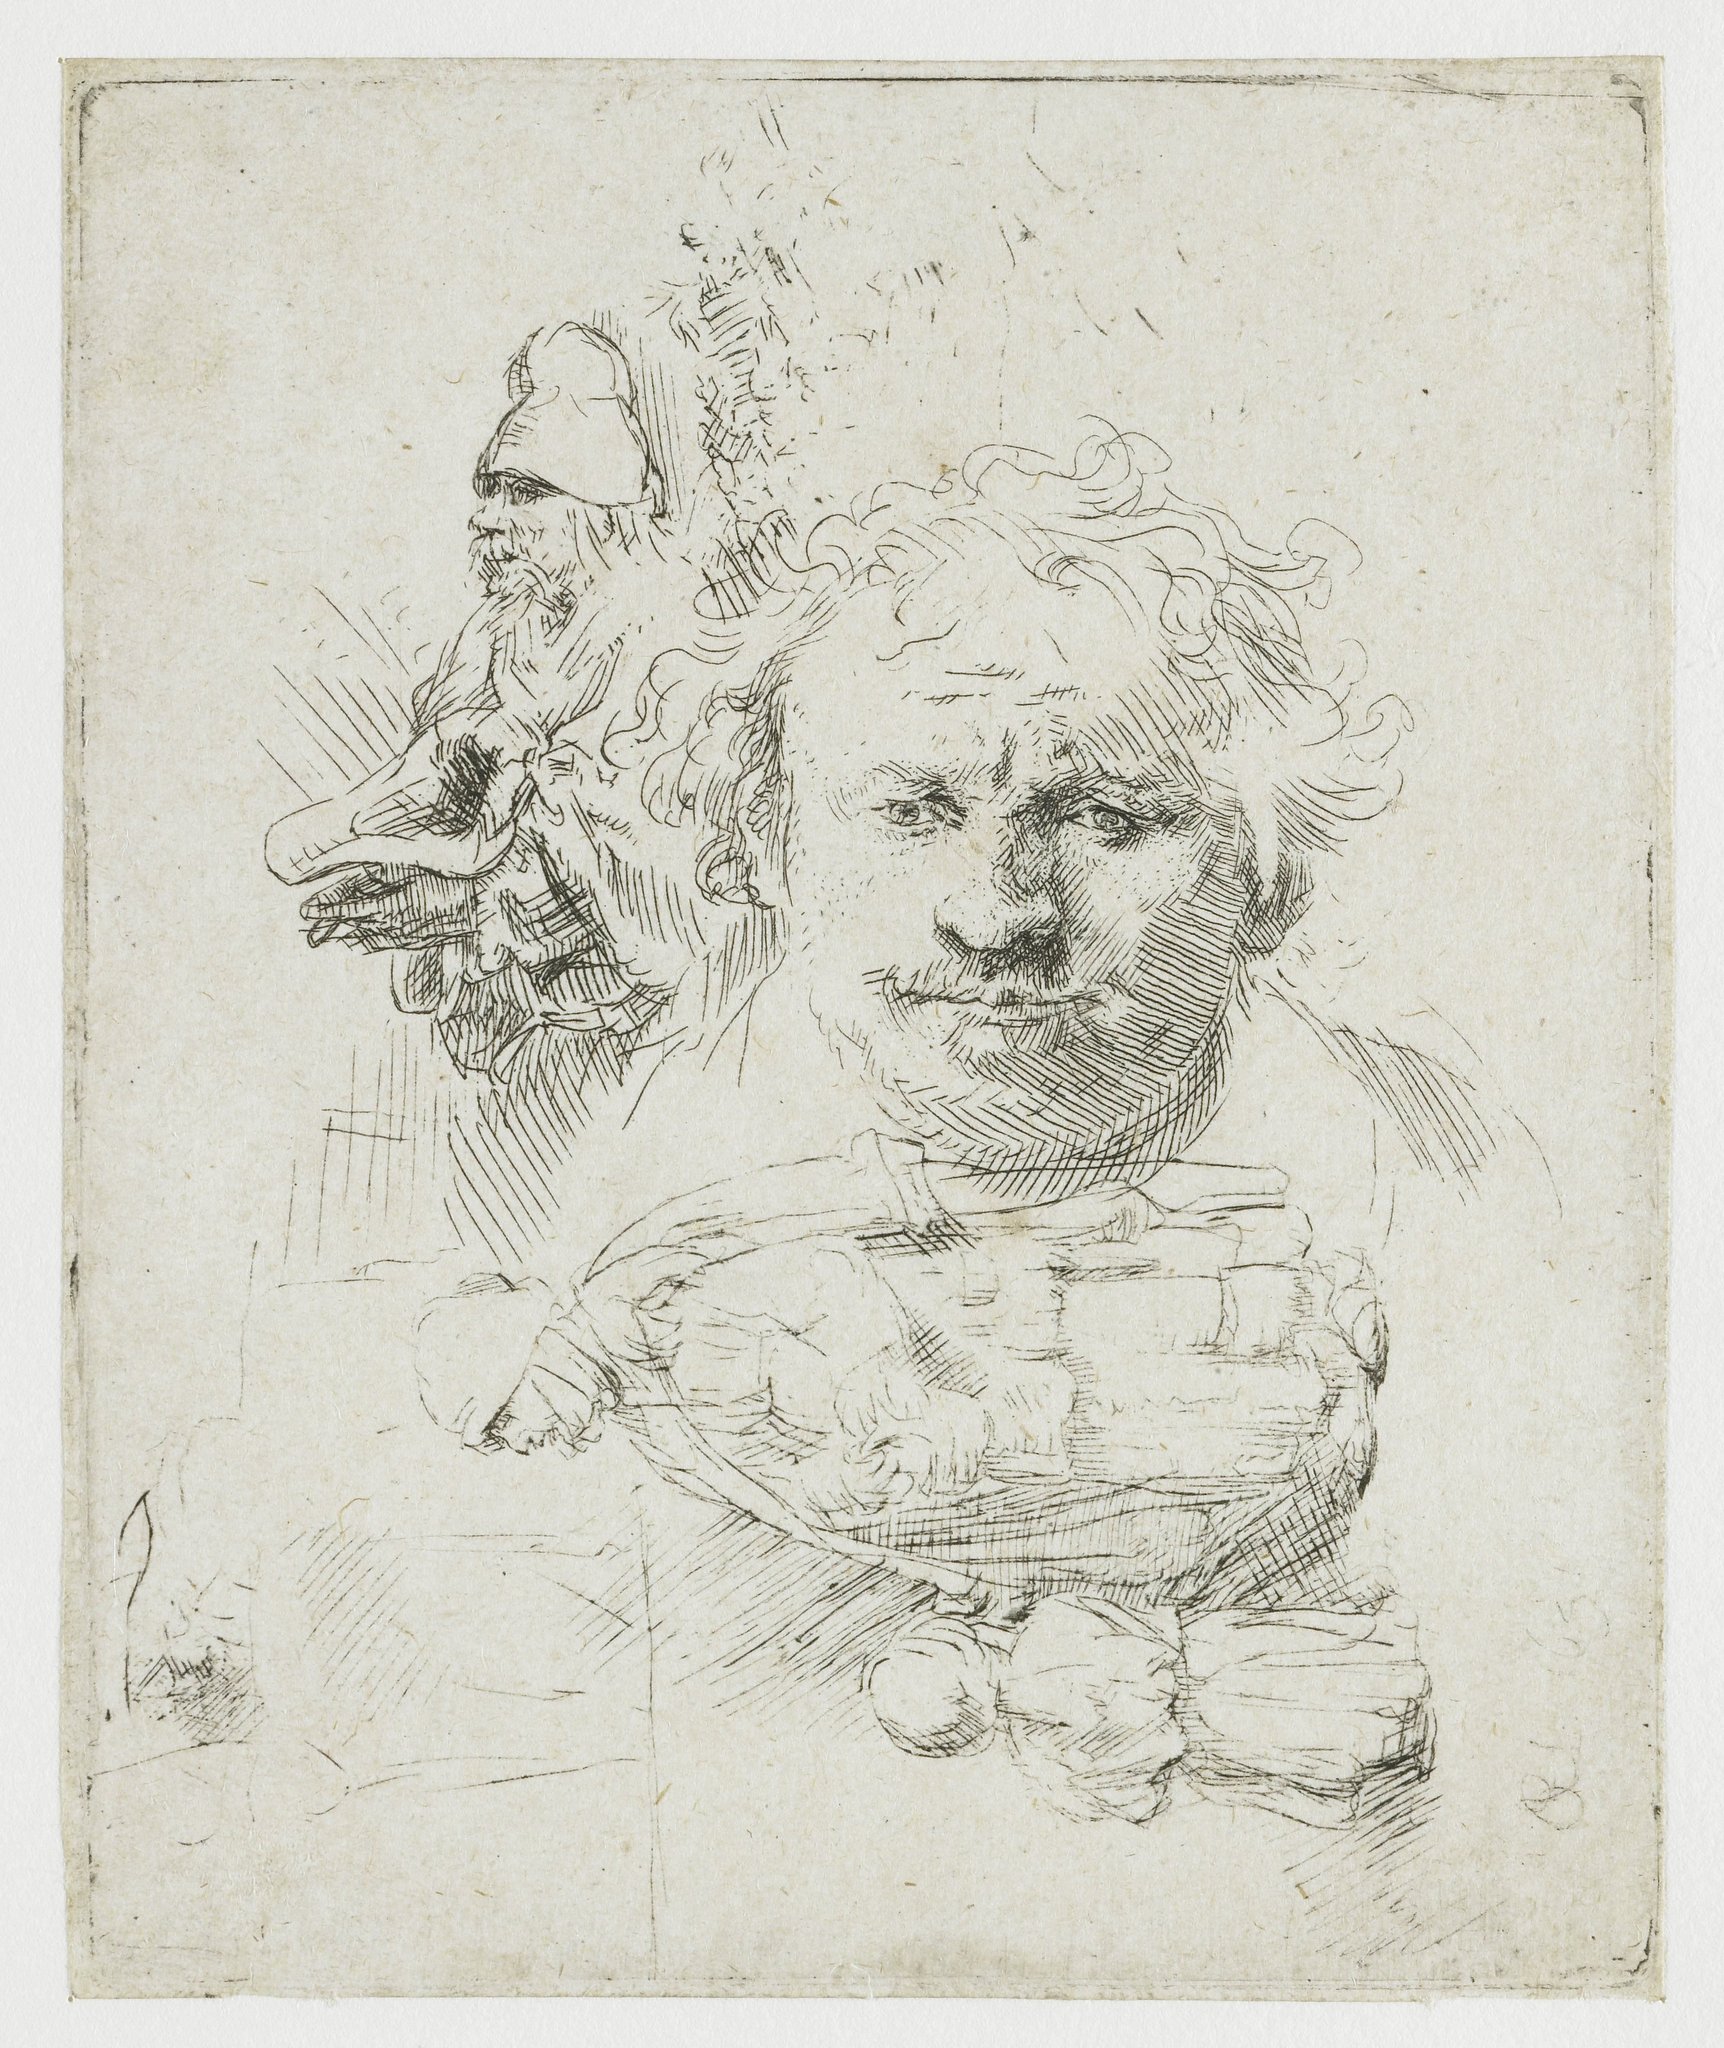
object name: print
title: Sheet of studies with the head of the artist, a beggar man, woman and child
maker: rembrandt van rijn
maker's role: draughtsman, painter, print maker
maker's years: 1606-1669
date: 1651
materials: paper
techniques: etching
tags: amsterdam, painter, print maker, draughtsman, rembrandt van rijn, beggar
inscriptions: mark: Lugt 2228, monogram and date: ‘RHL 1631’, inscription: ‘338 (doorgestreept) en 337’ Gersaint nummer